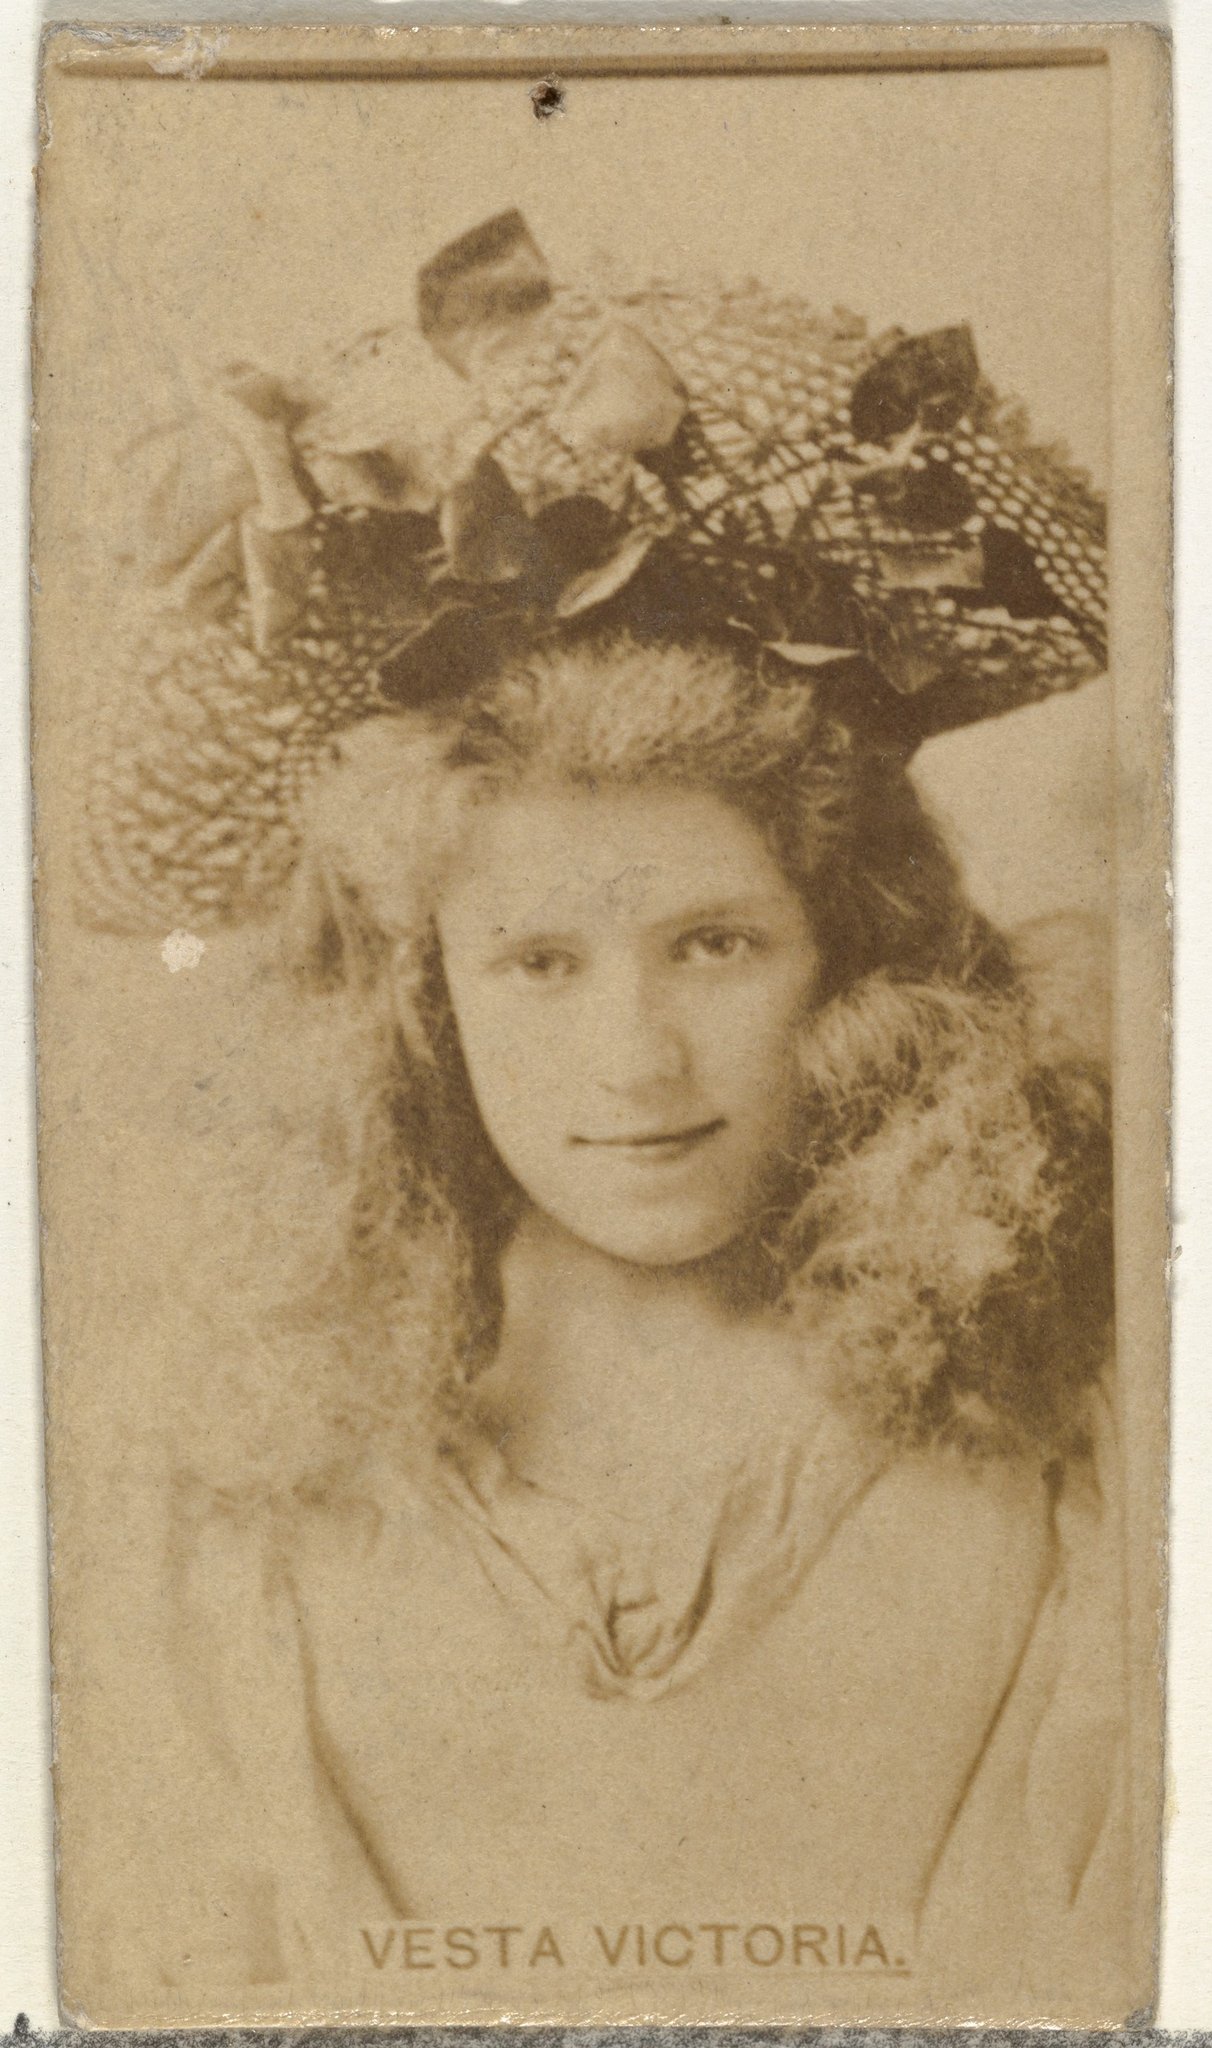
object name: photograph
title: Vesta Victoria, from the Actors and Actresses series (N145-8) issued by Duke Sons & Co. to promote Duke Cigarettes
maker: w. duke, sons & co.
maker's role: publisher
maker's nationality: american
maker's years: 1870-1920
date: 1891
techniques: albumen silver print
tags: portraits,women,actresses